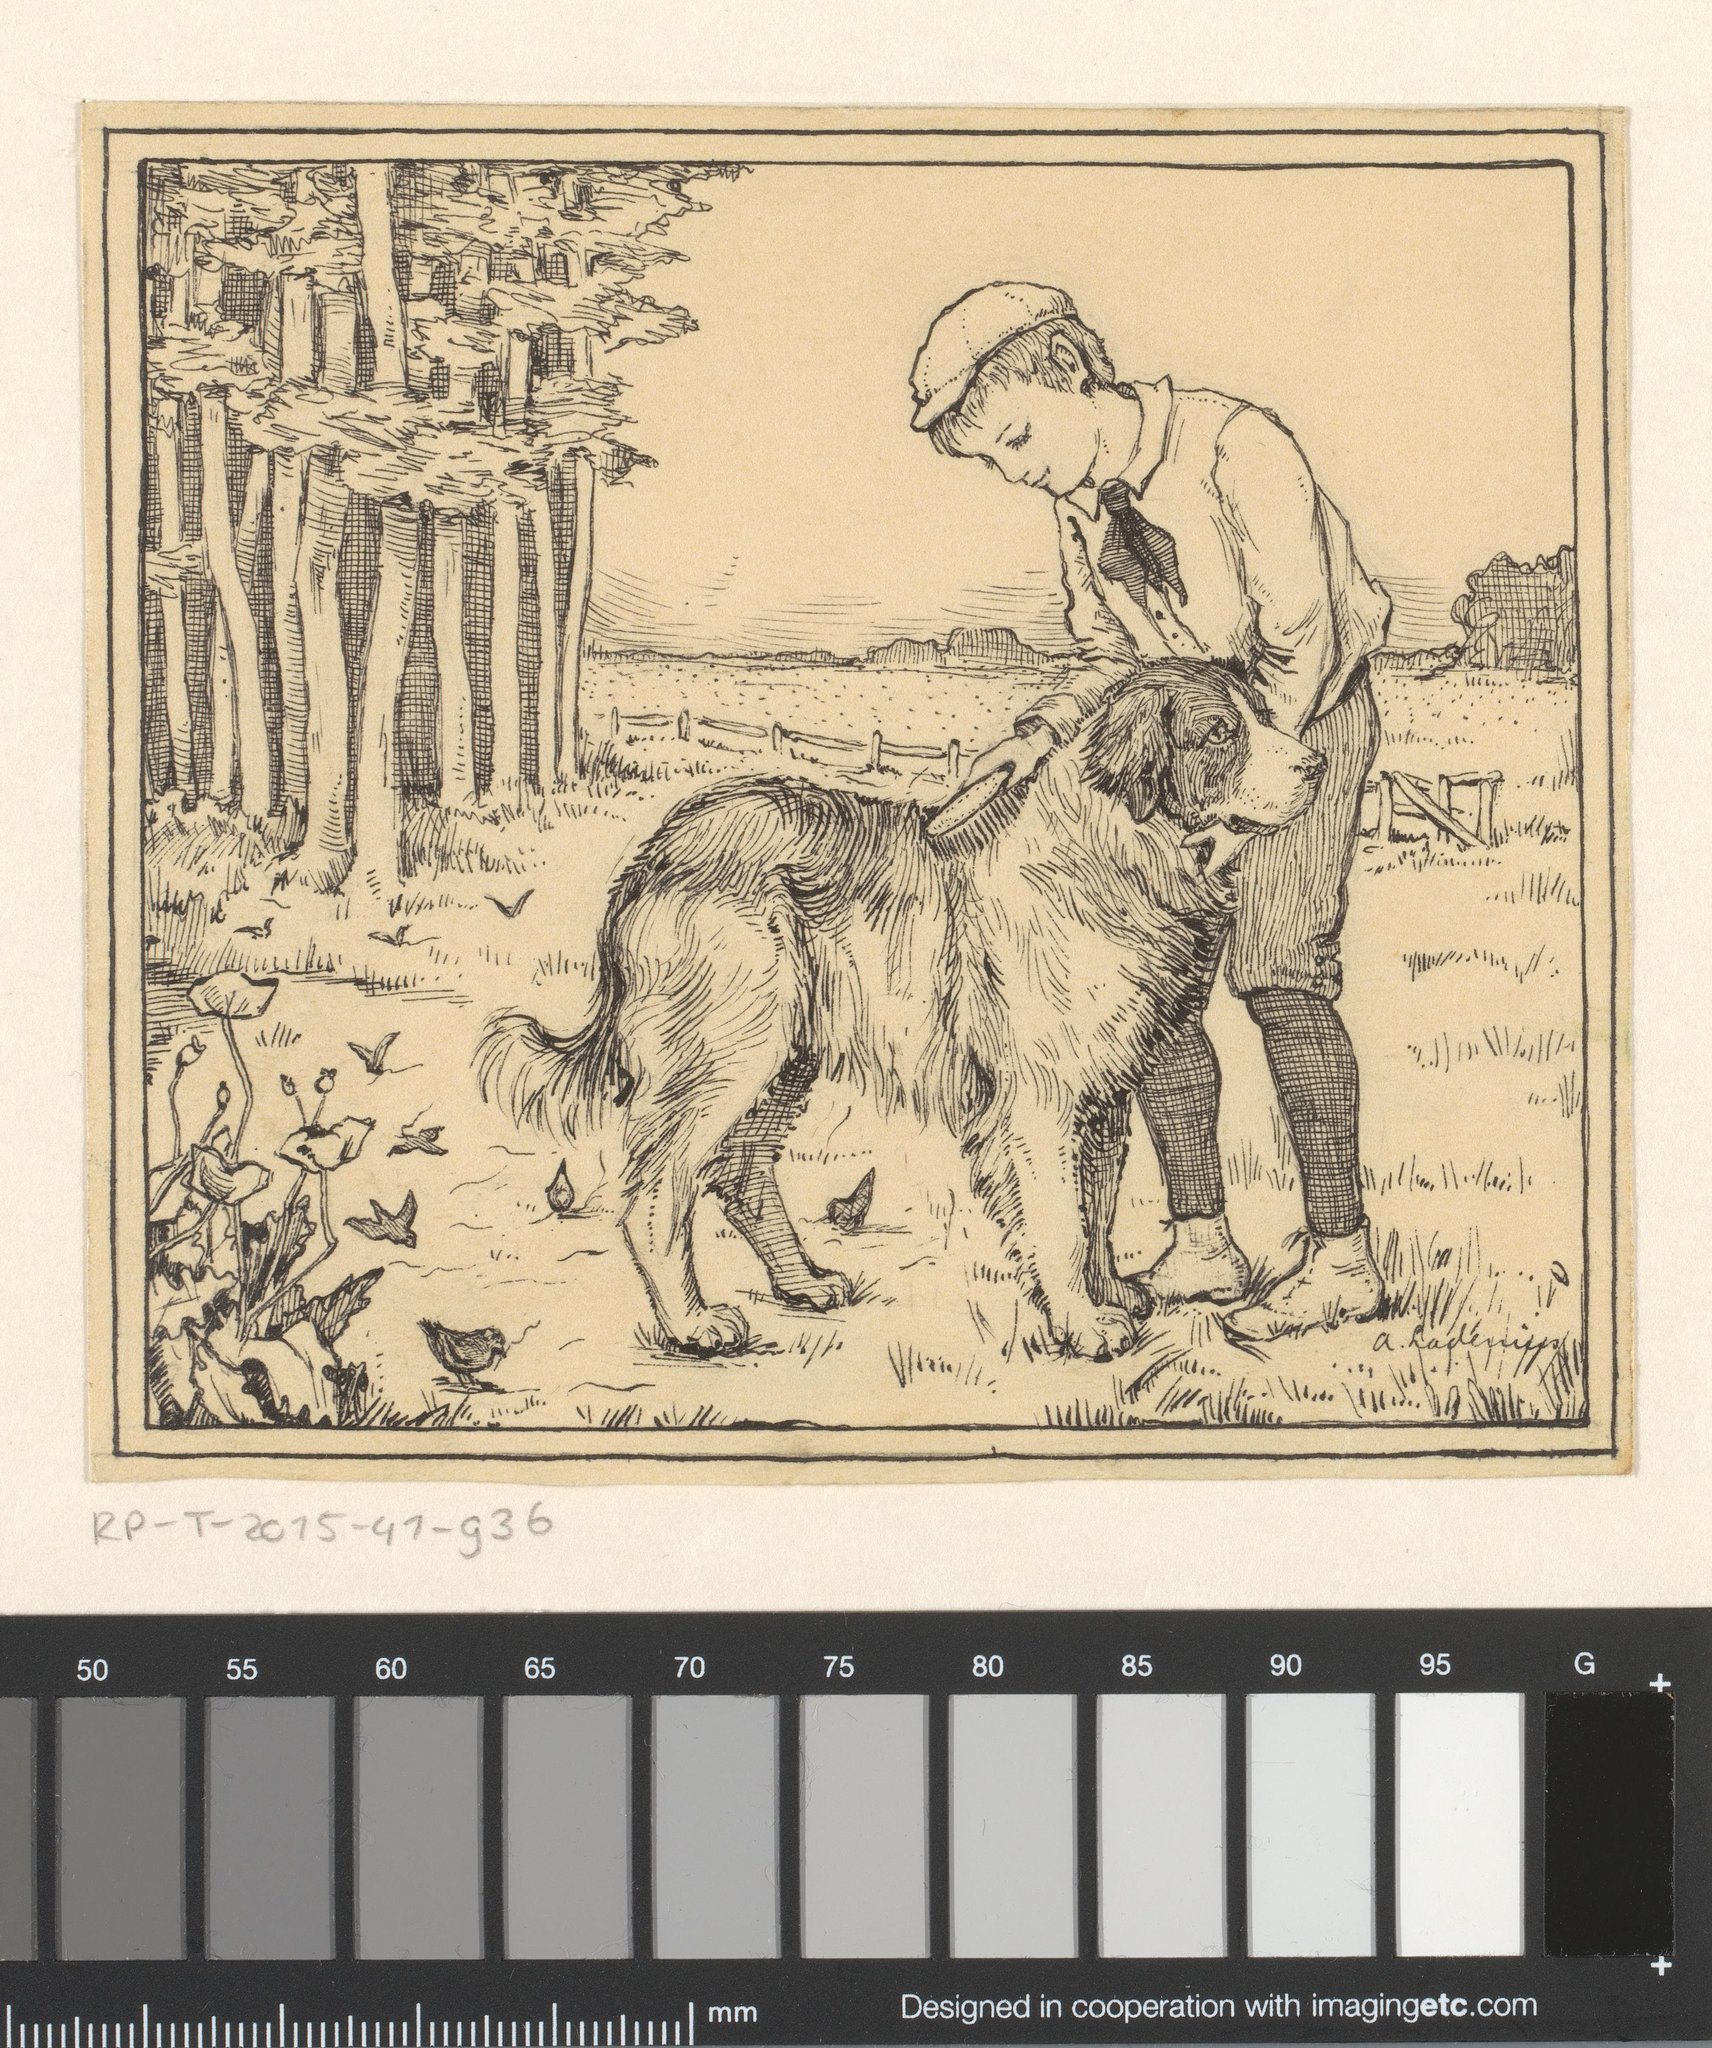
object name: boekillustratie ontwerp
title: Jongen borstelt een hond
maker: adri ladenius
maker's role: draughtsman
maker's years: 1883-1953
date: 1893-1953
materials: ink, paper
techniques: pen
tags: trees, dog (+ grooming an animal), dog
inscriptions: signature: ‘A. Ladenius’, collector's mark: Lugt 2228, annotation: ‘Het voert/ vogelnest[...]’, :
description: Een jongen staat in een landschap en borstelt een langharige hond. Op de achtergrond een bomengroep.